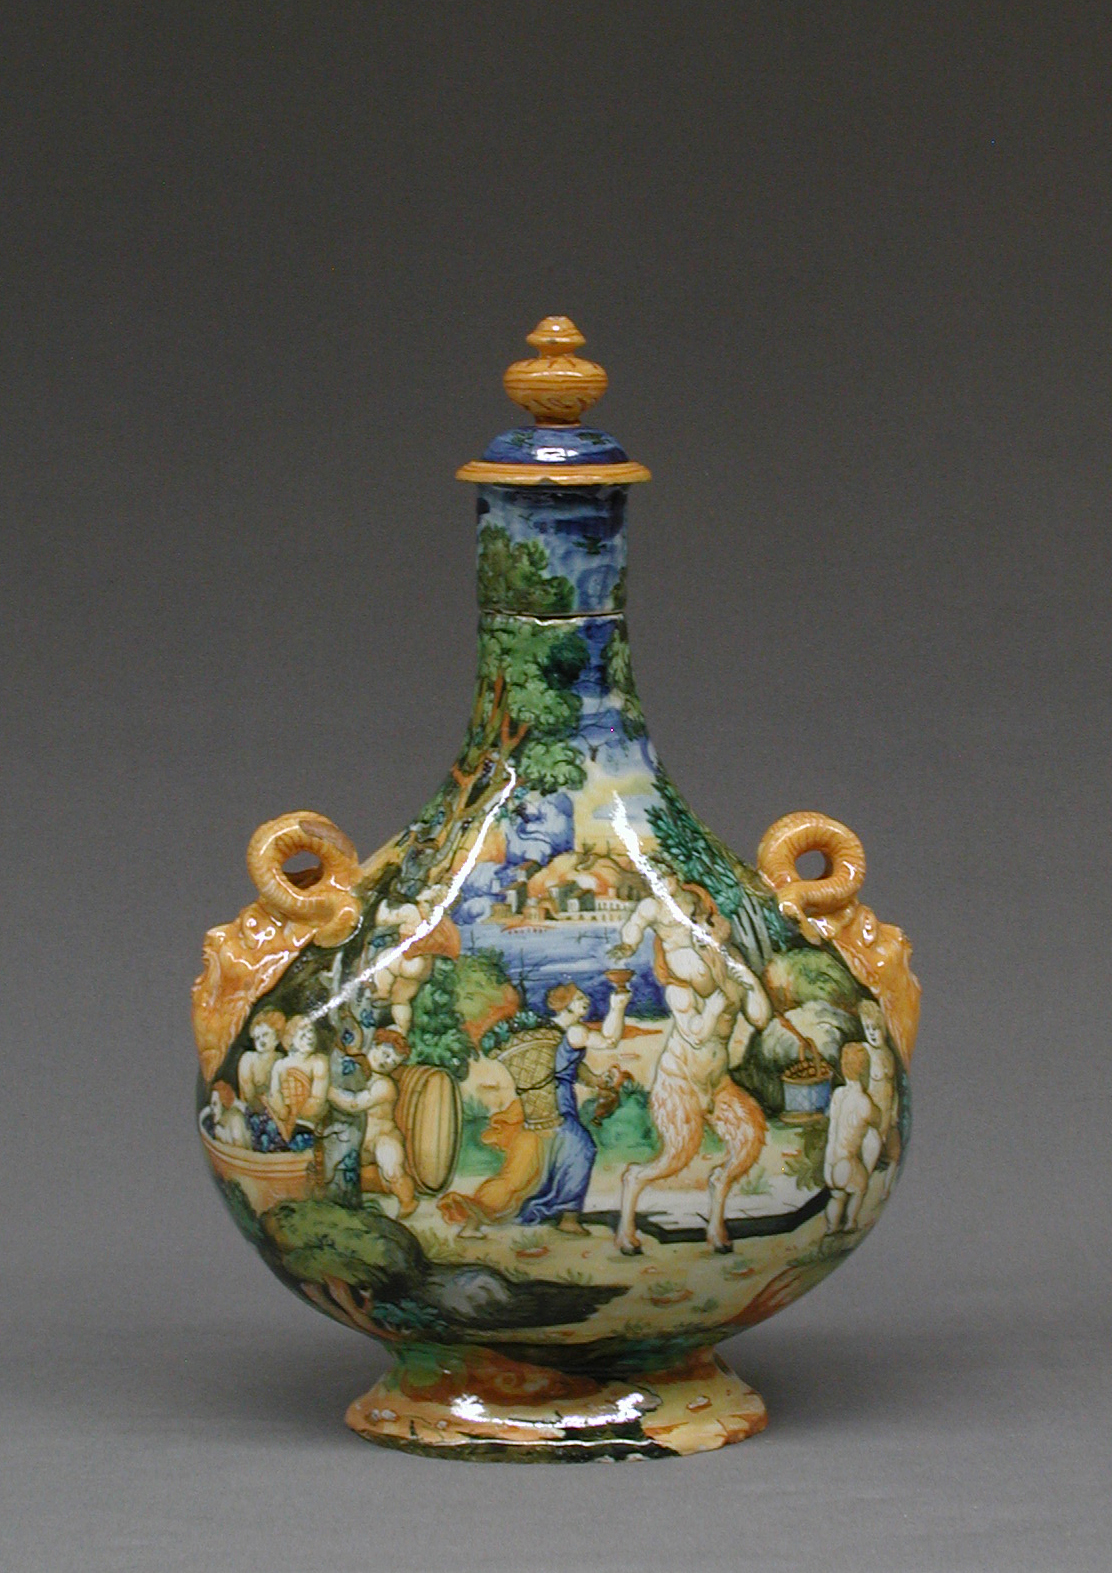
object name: pilgrim bottle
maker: orazio fontana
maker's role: maker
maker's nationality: italian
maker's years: 1505-1576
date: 1550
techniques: maiolica, glazing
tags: human figures,satyrs,trees